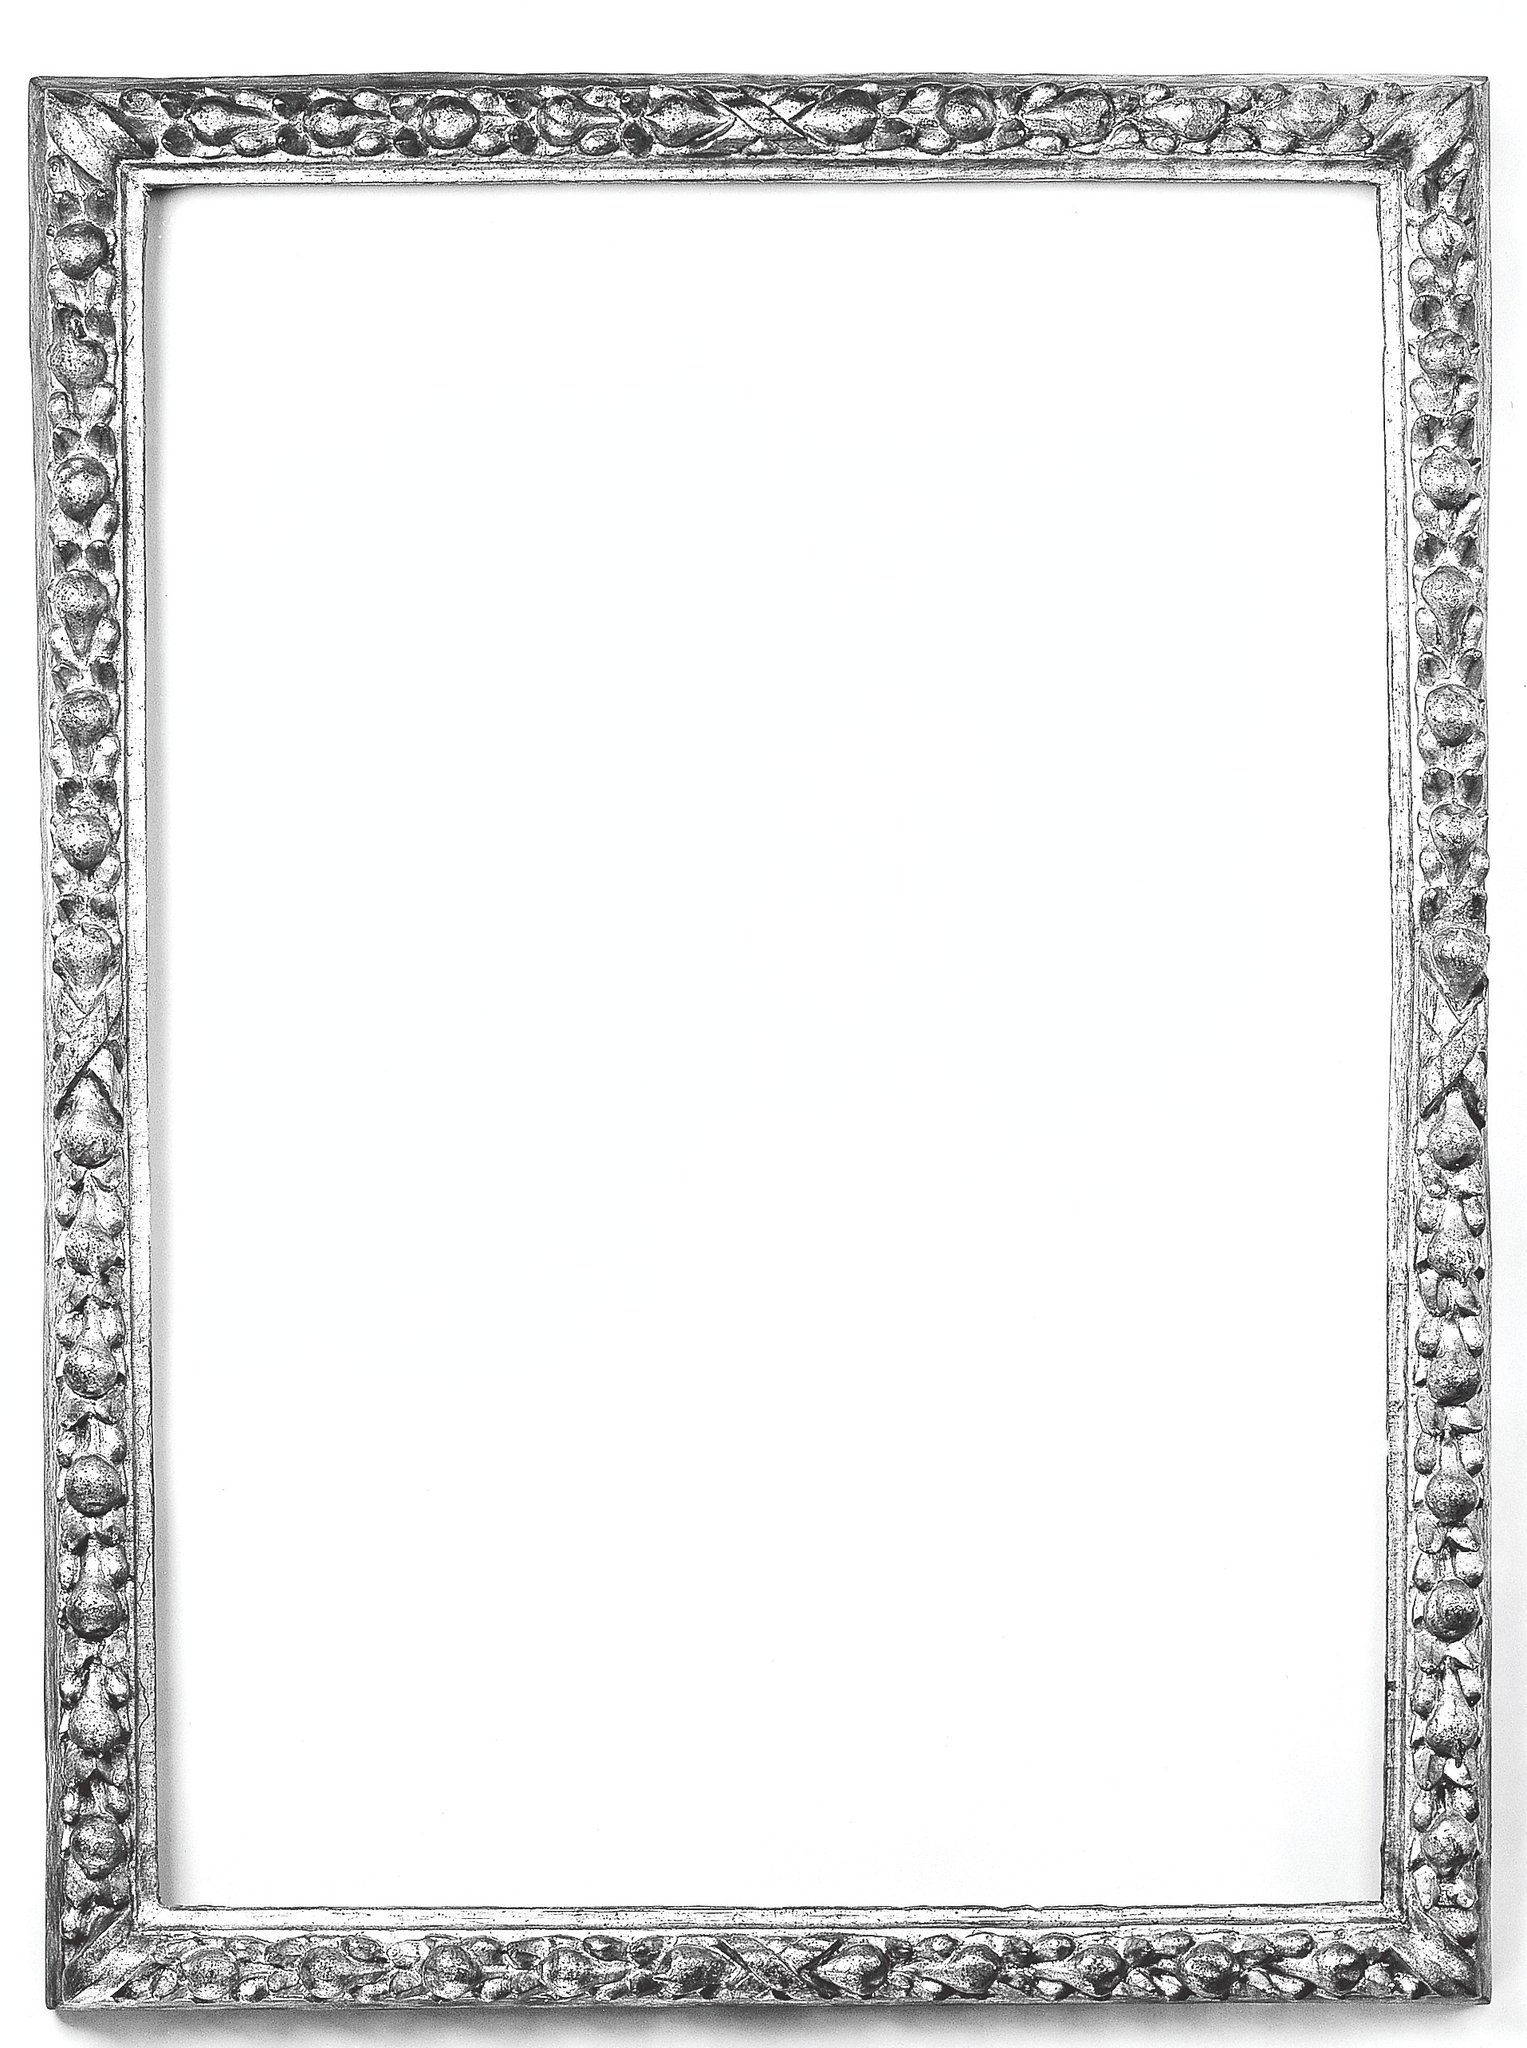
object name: frame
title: Astragal frame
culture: italian, veneto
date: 1601-1633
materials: wood